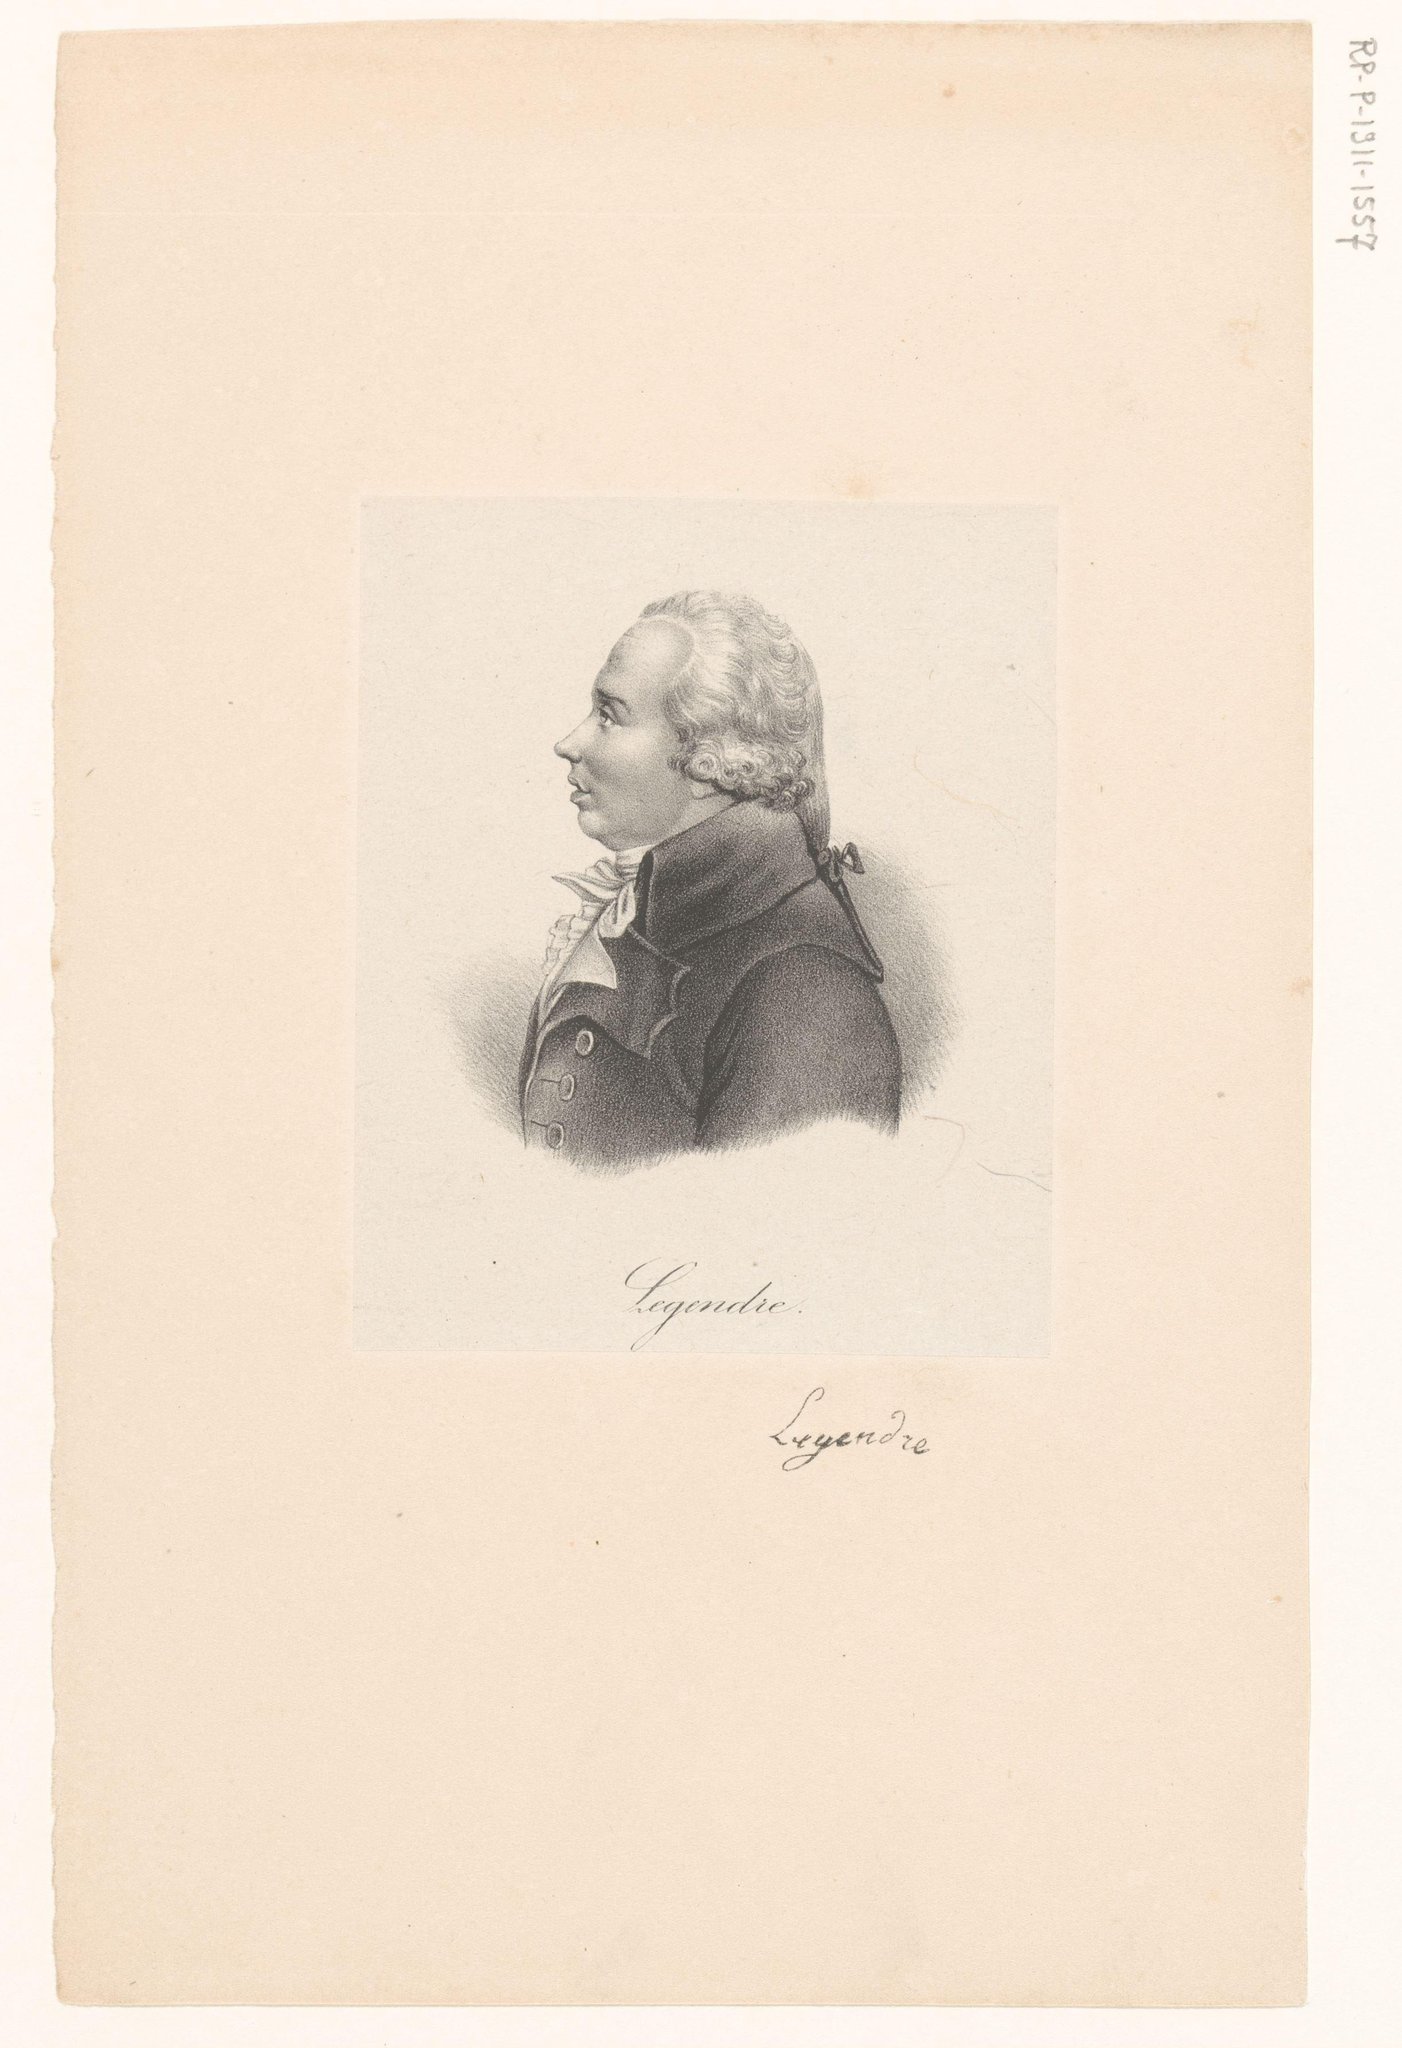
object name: print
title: Portret van Louis Legendre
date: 1818-1842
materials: paper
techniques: lithograph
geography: paris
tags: historical persons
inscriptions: collector's mark: Lugt 2228a